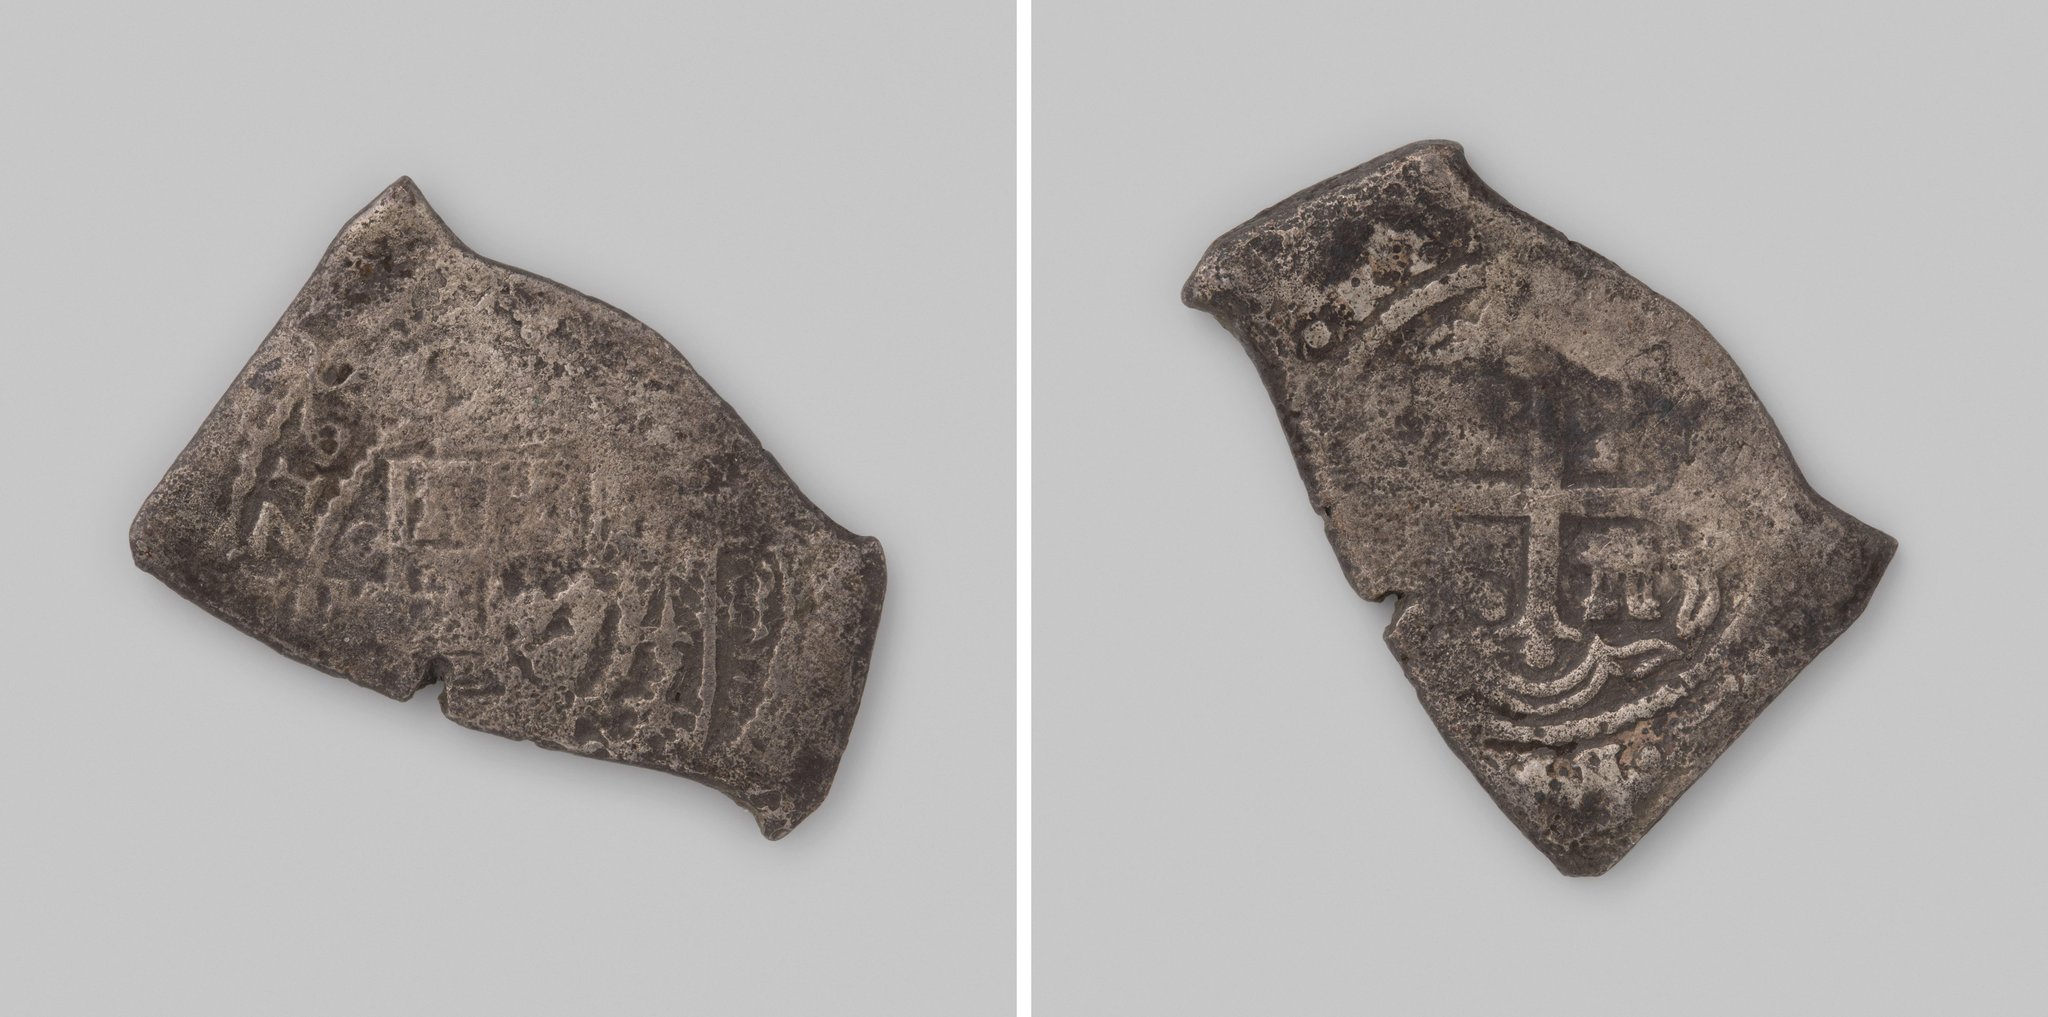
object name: coin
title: Reaal van achten, geslagen te Mexico, munt uit het wrak van de Oost-Indiëvaarder 't Vliegend Hart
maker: Anonymous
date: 1716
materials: silver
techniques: striking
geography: mexico city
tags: filips v (koning van spanje)